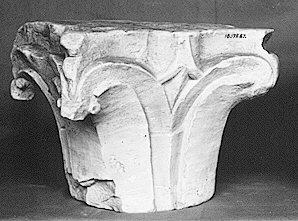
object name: capital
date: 501-700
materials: limestone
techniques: carving, relief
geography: egypt